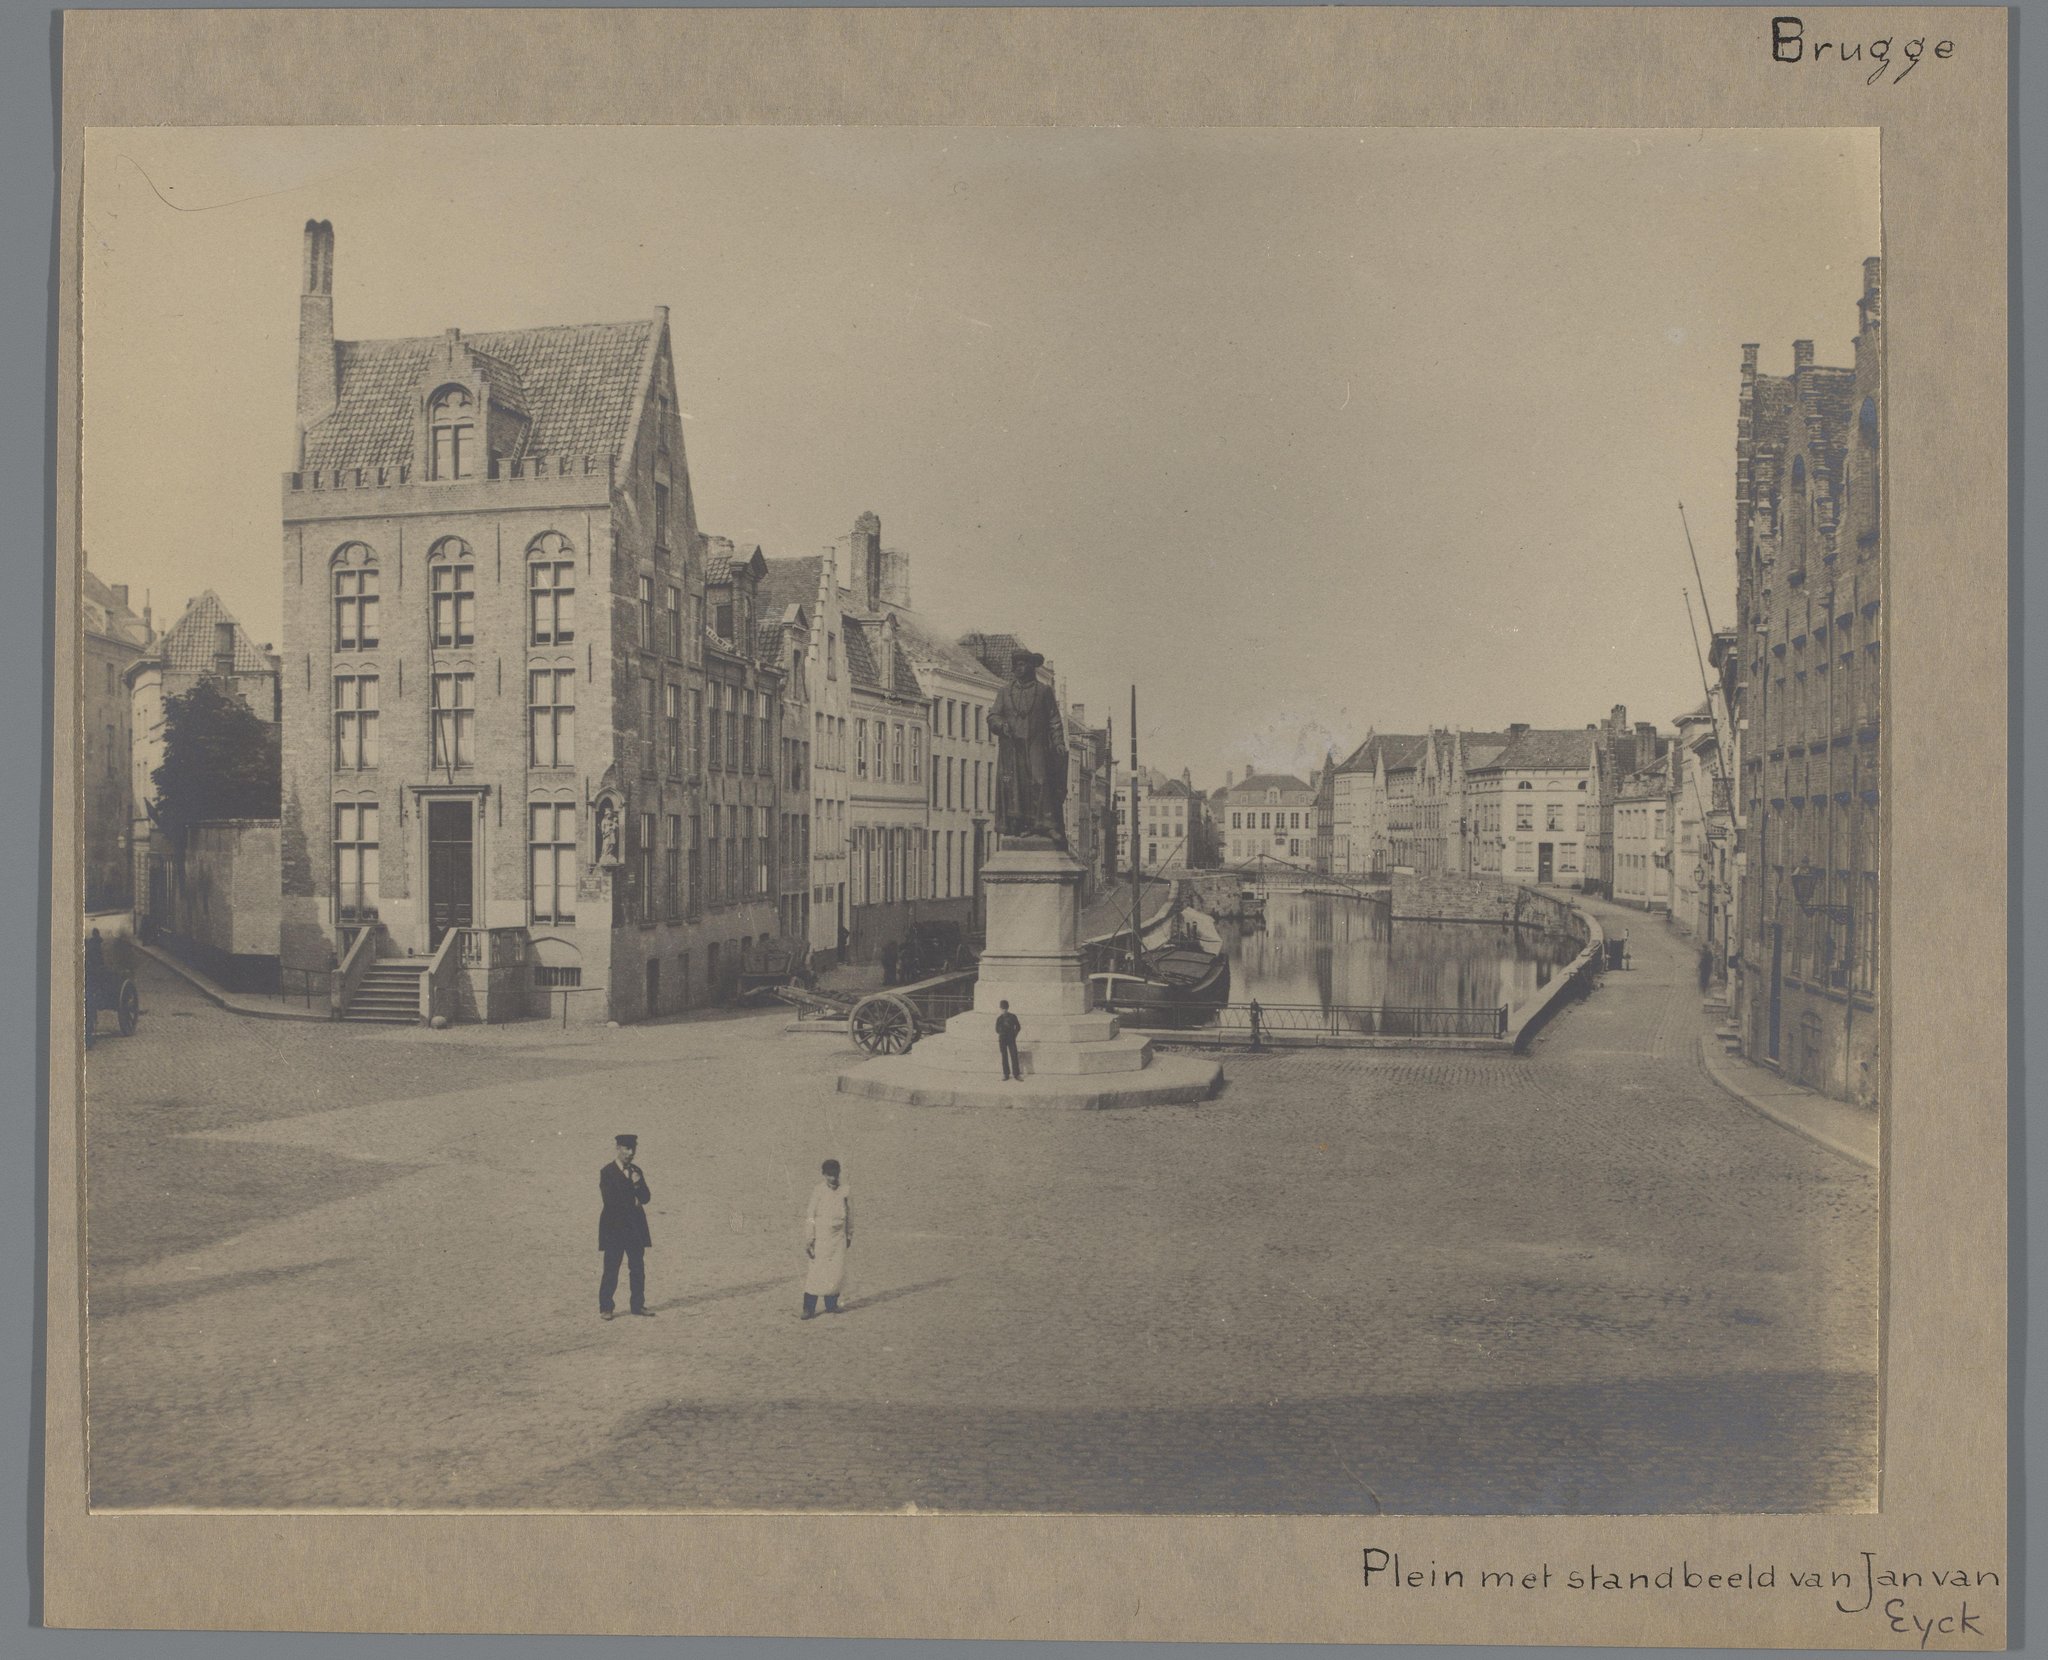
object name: photograph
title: Brugge. Plein met standbeeld van Jan van Eyck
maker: Anonymous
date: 1880-1930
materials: photographic support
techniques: gelatin silver print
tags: bruges, draughtsman, jan van eyck